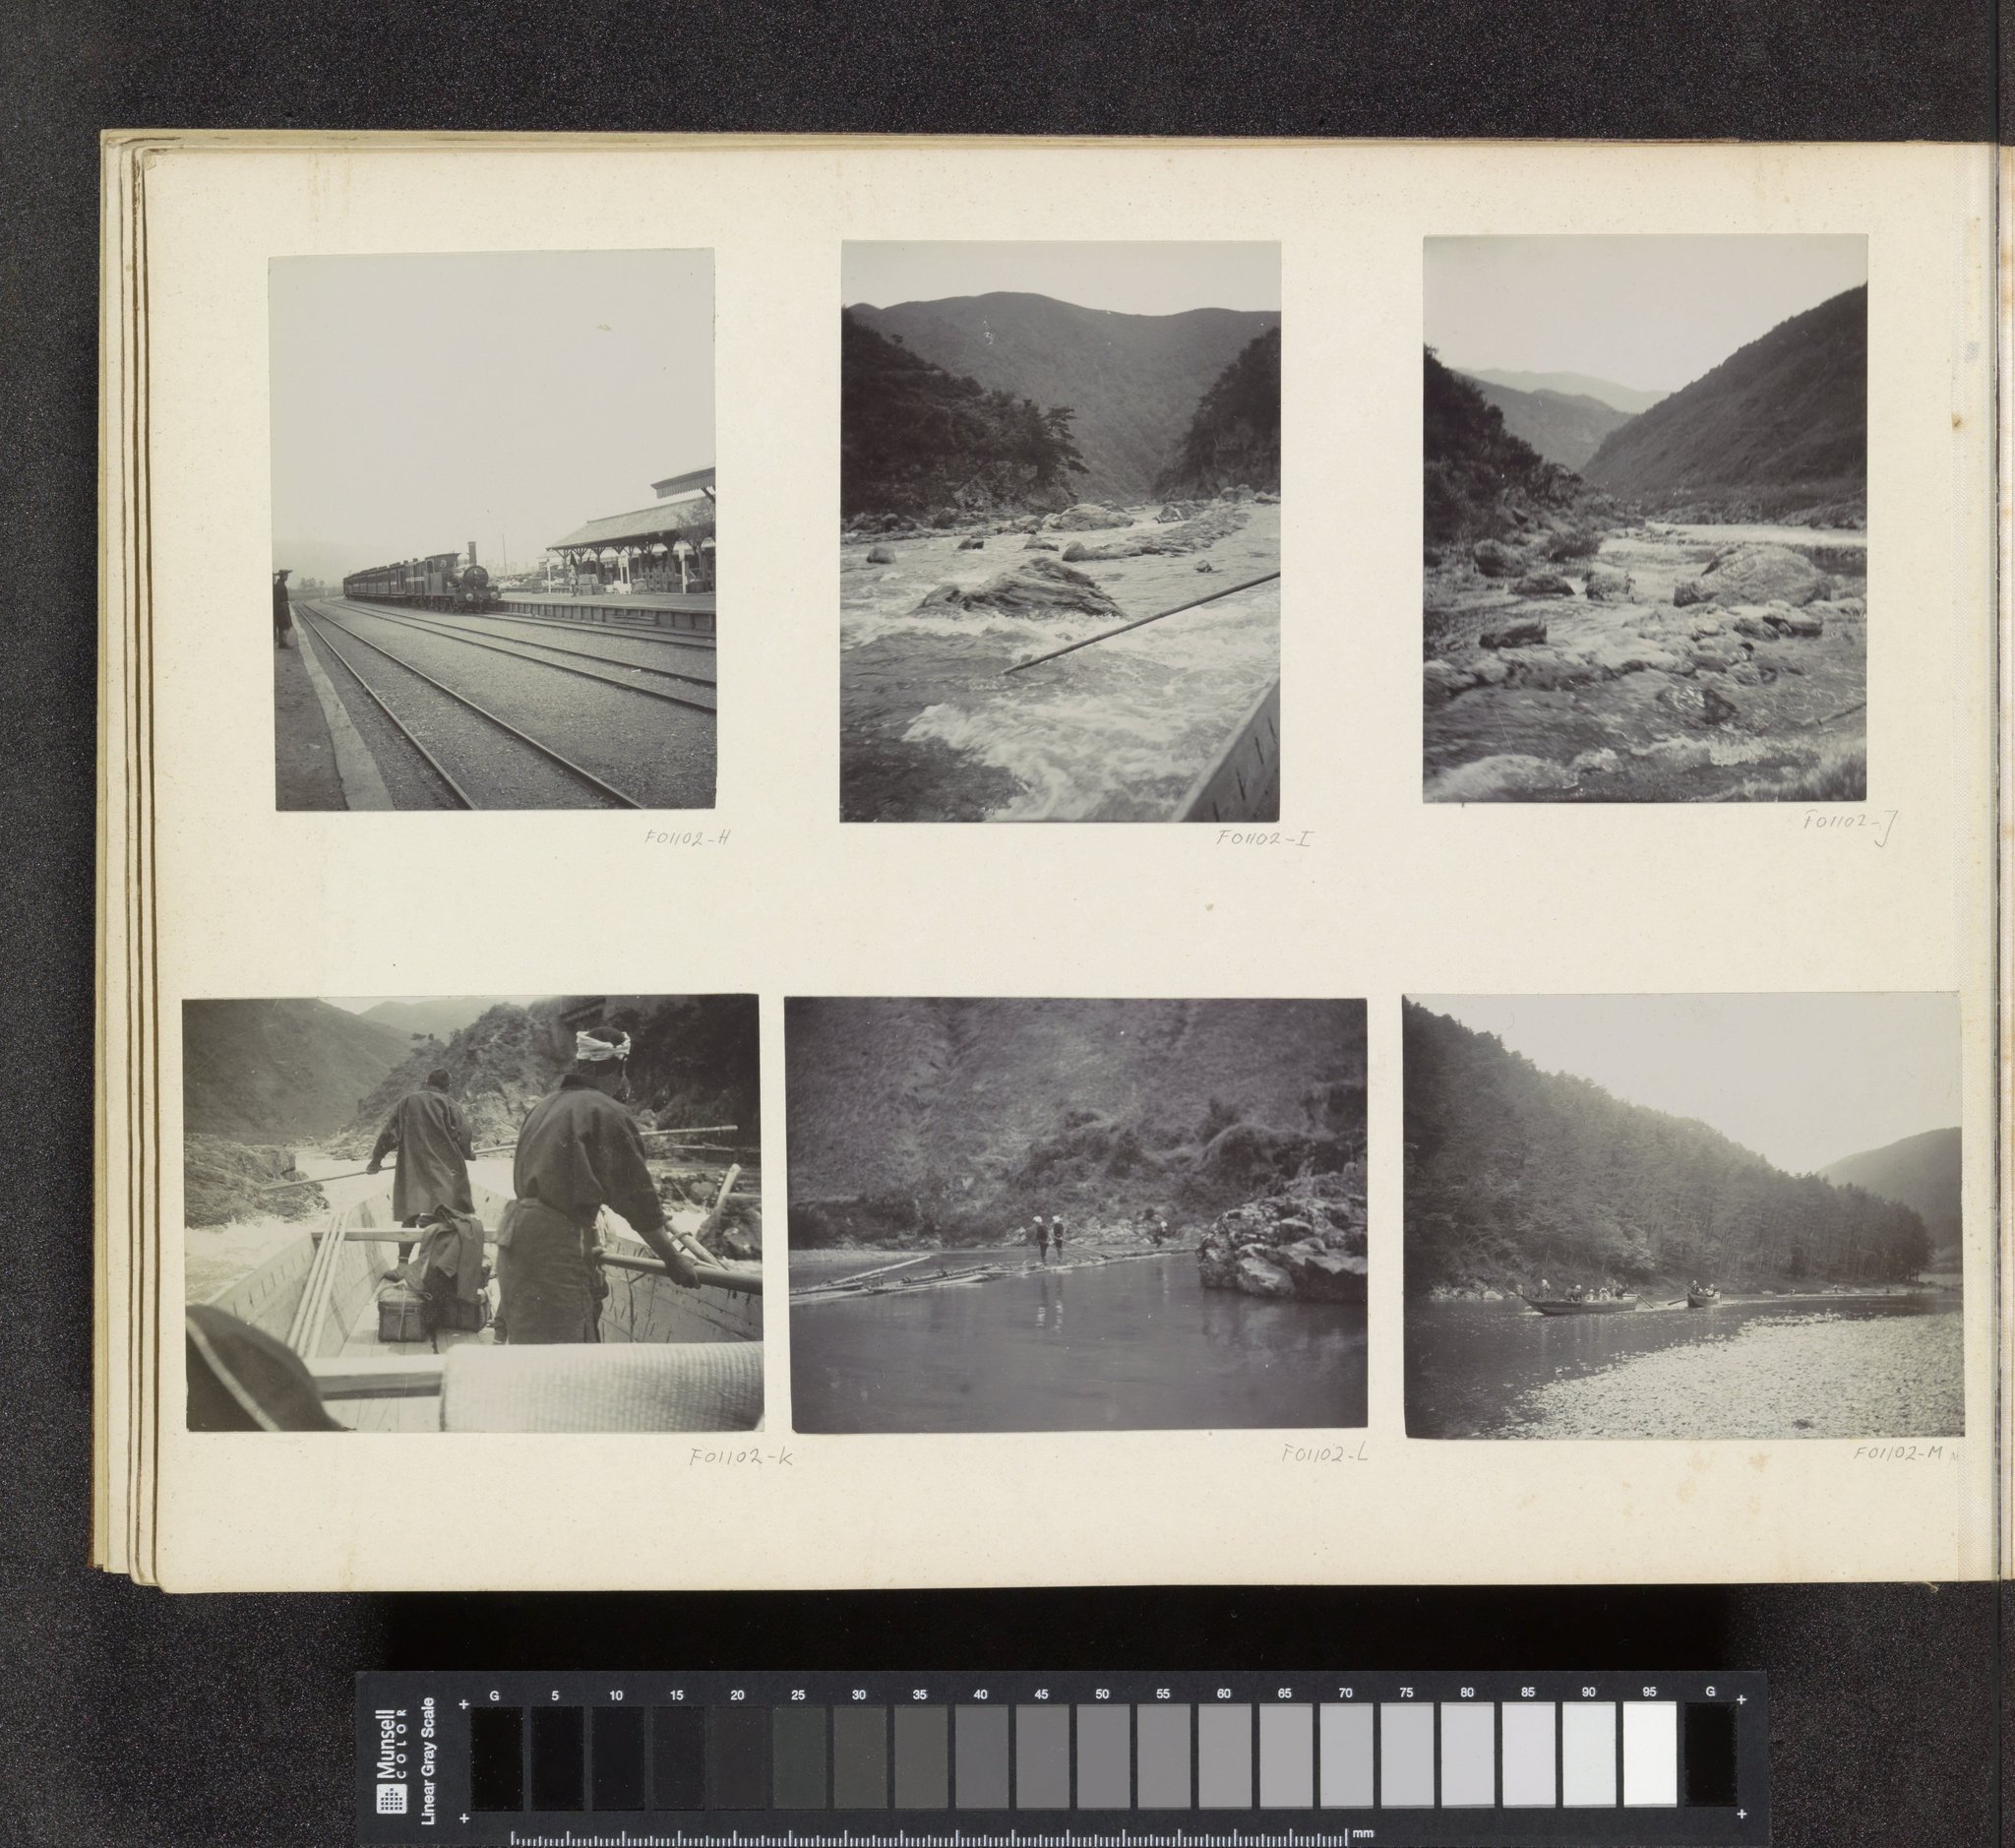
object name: album leaf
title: Trein bij een station in Japan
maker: Anonymous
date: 1900-1940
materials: cardboard, paper, photographic support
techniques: gelatin silver print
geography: japan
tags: platform (railway, tramway), railway, train, japan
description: Onderdeel van Reisalbum met foto's van bezienswaardigheden in Japan.